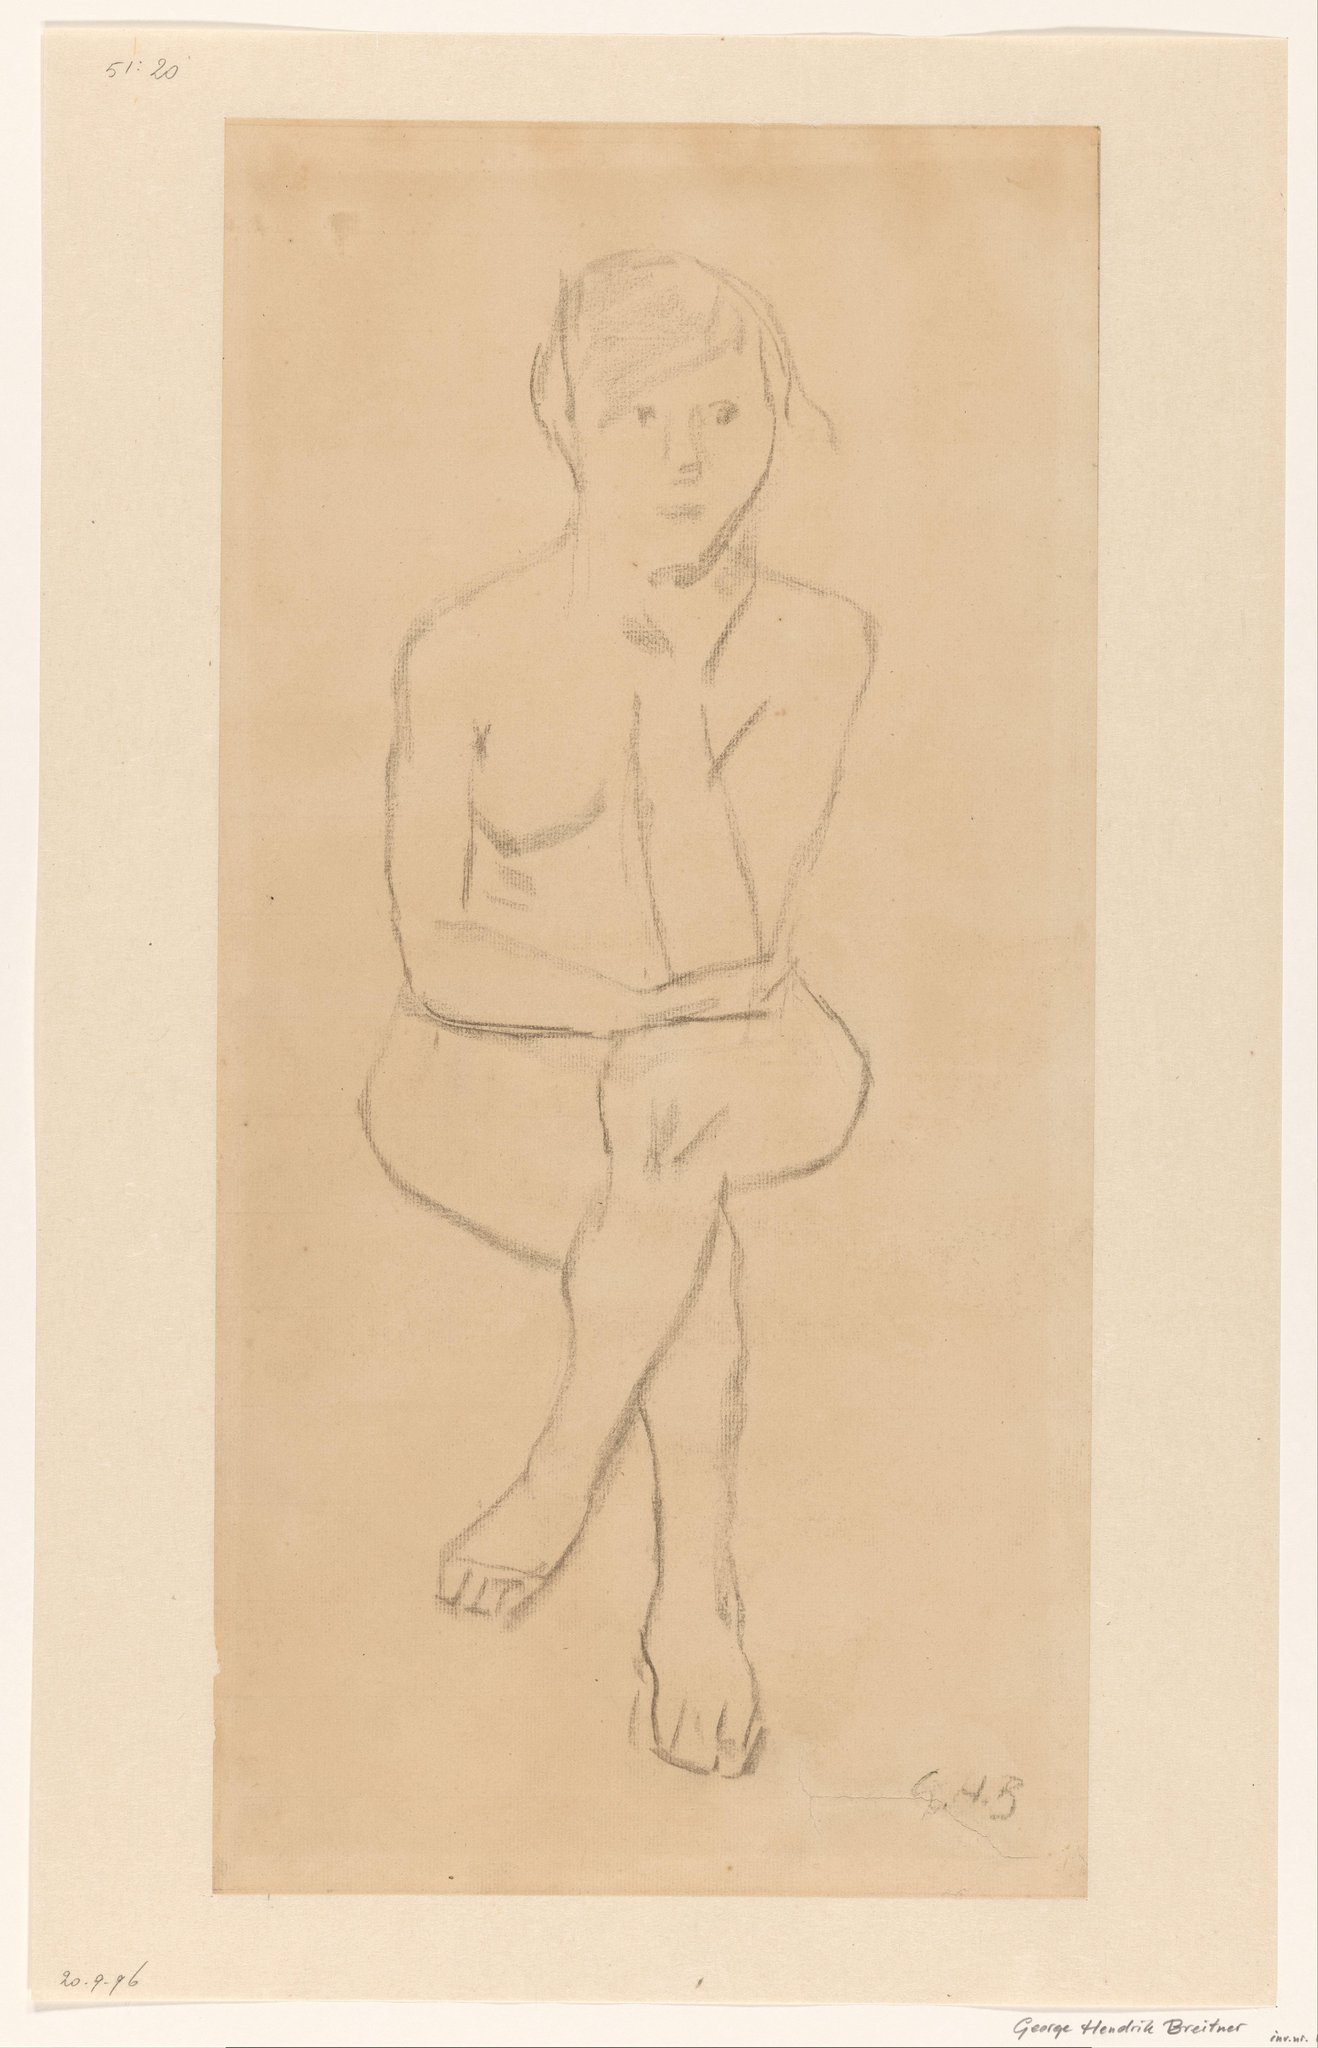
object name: drawing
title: Zittend vrouwlijk naakt, van voren gezien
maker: george hendrik breitner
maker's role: draughtsman, painter, print maker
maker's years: 1857-1923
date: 1867-1923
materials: charcoal, paper